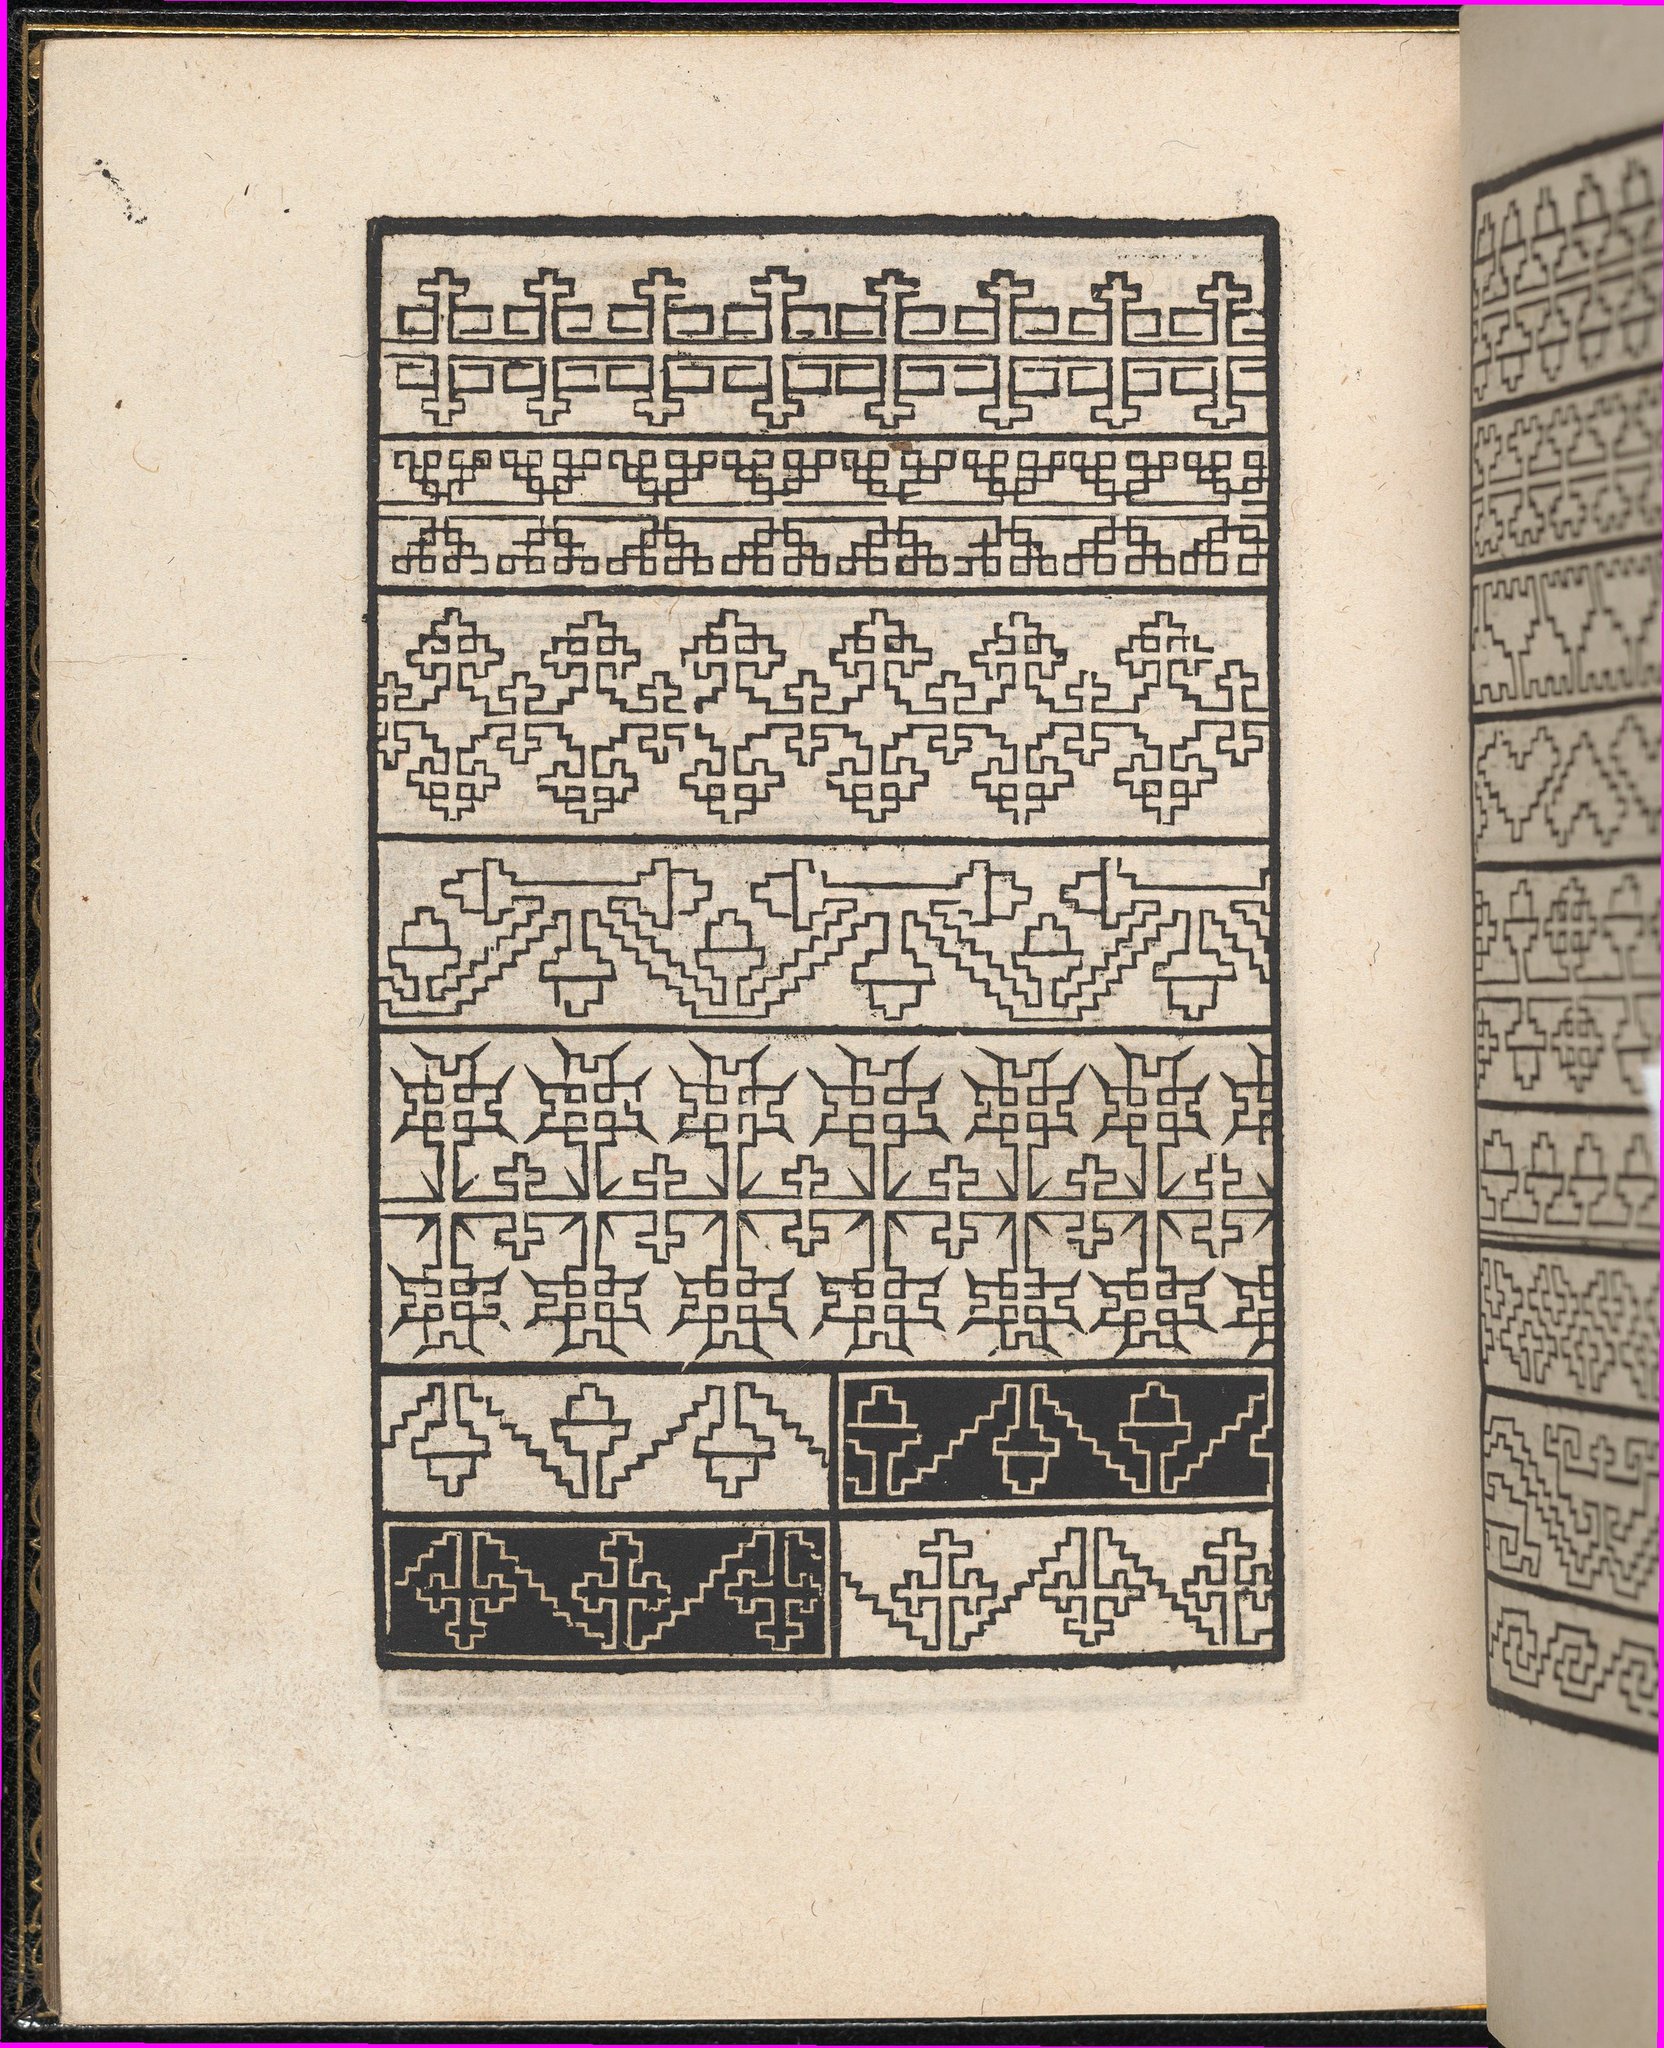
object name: book print ornament architecture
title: Page from Ein new kunstlich Modelbuch...(Page 46v)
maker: peter quentel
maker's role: publisher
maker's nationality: german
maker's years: 1500-1550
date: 1544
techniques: woodcut